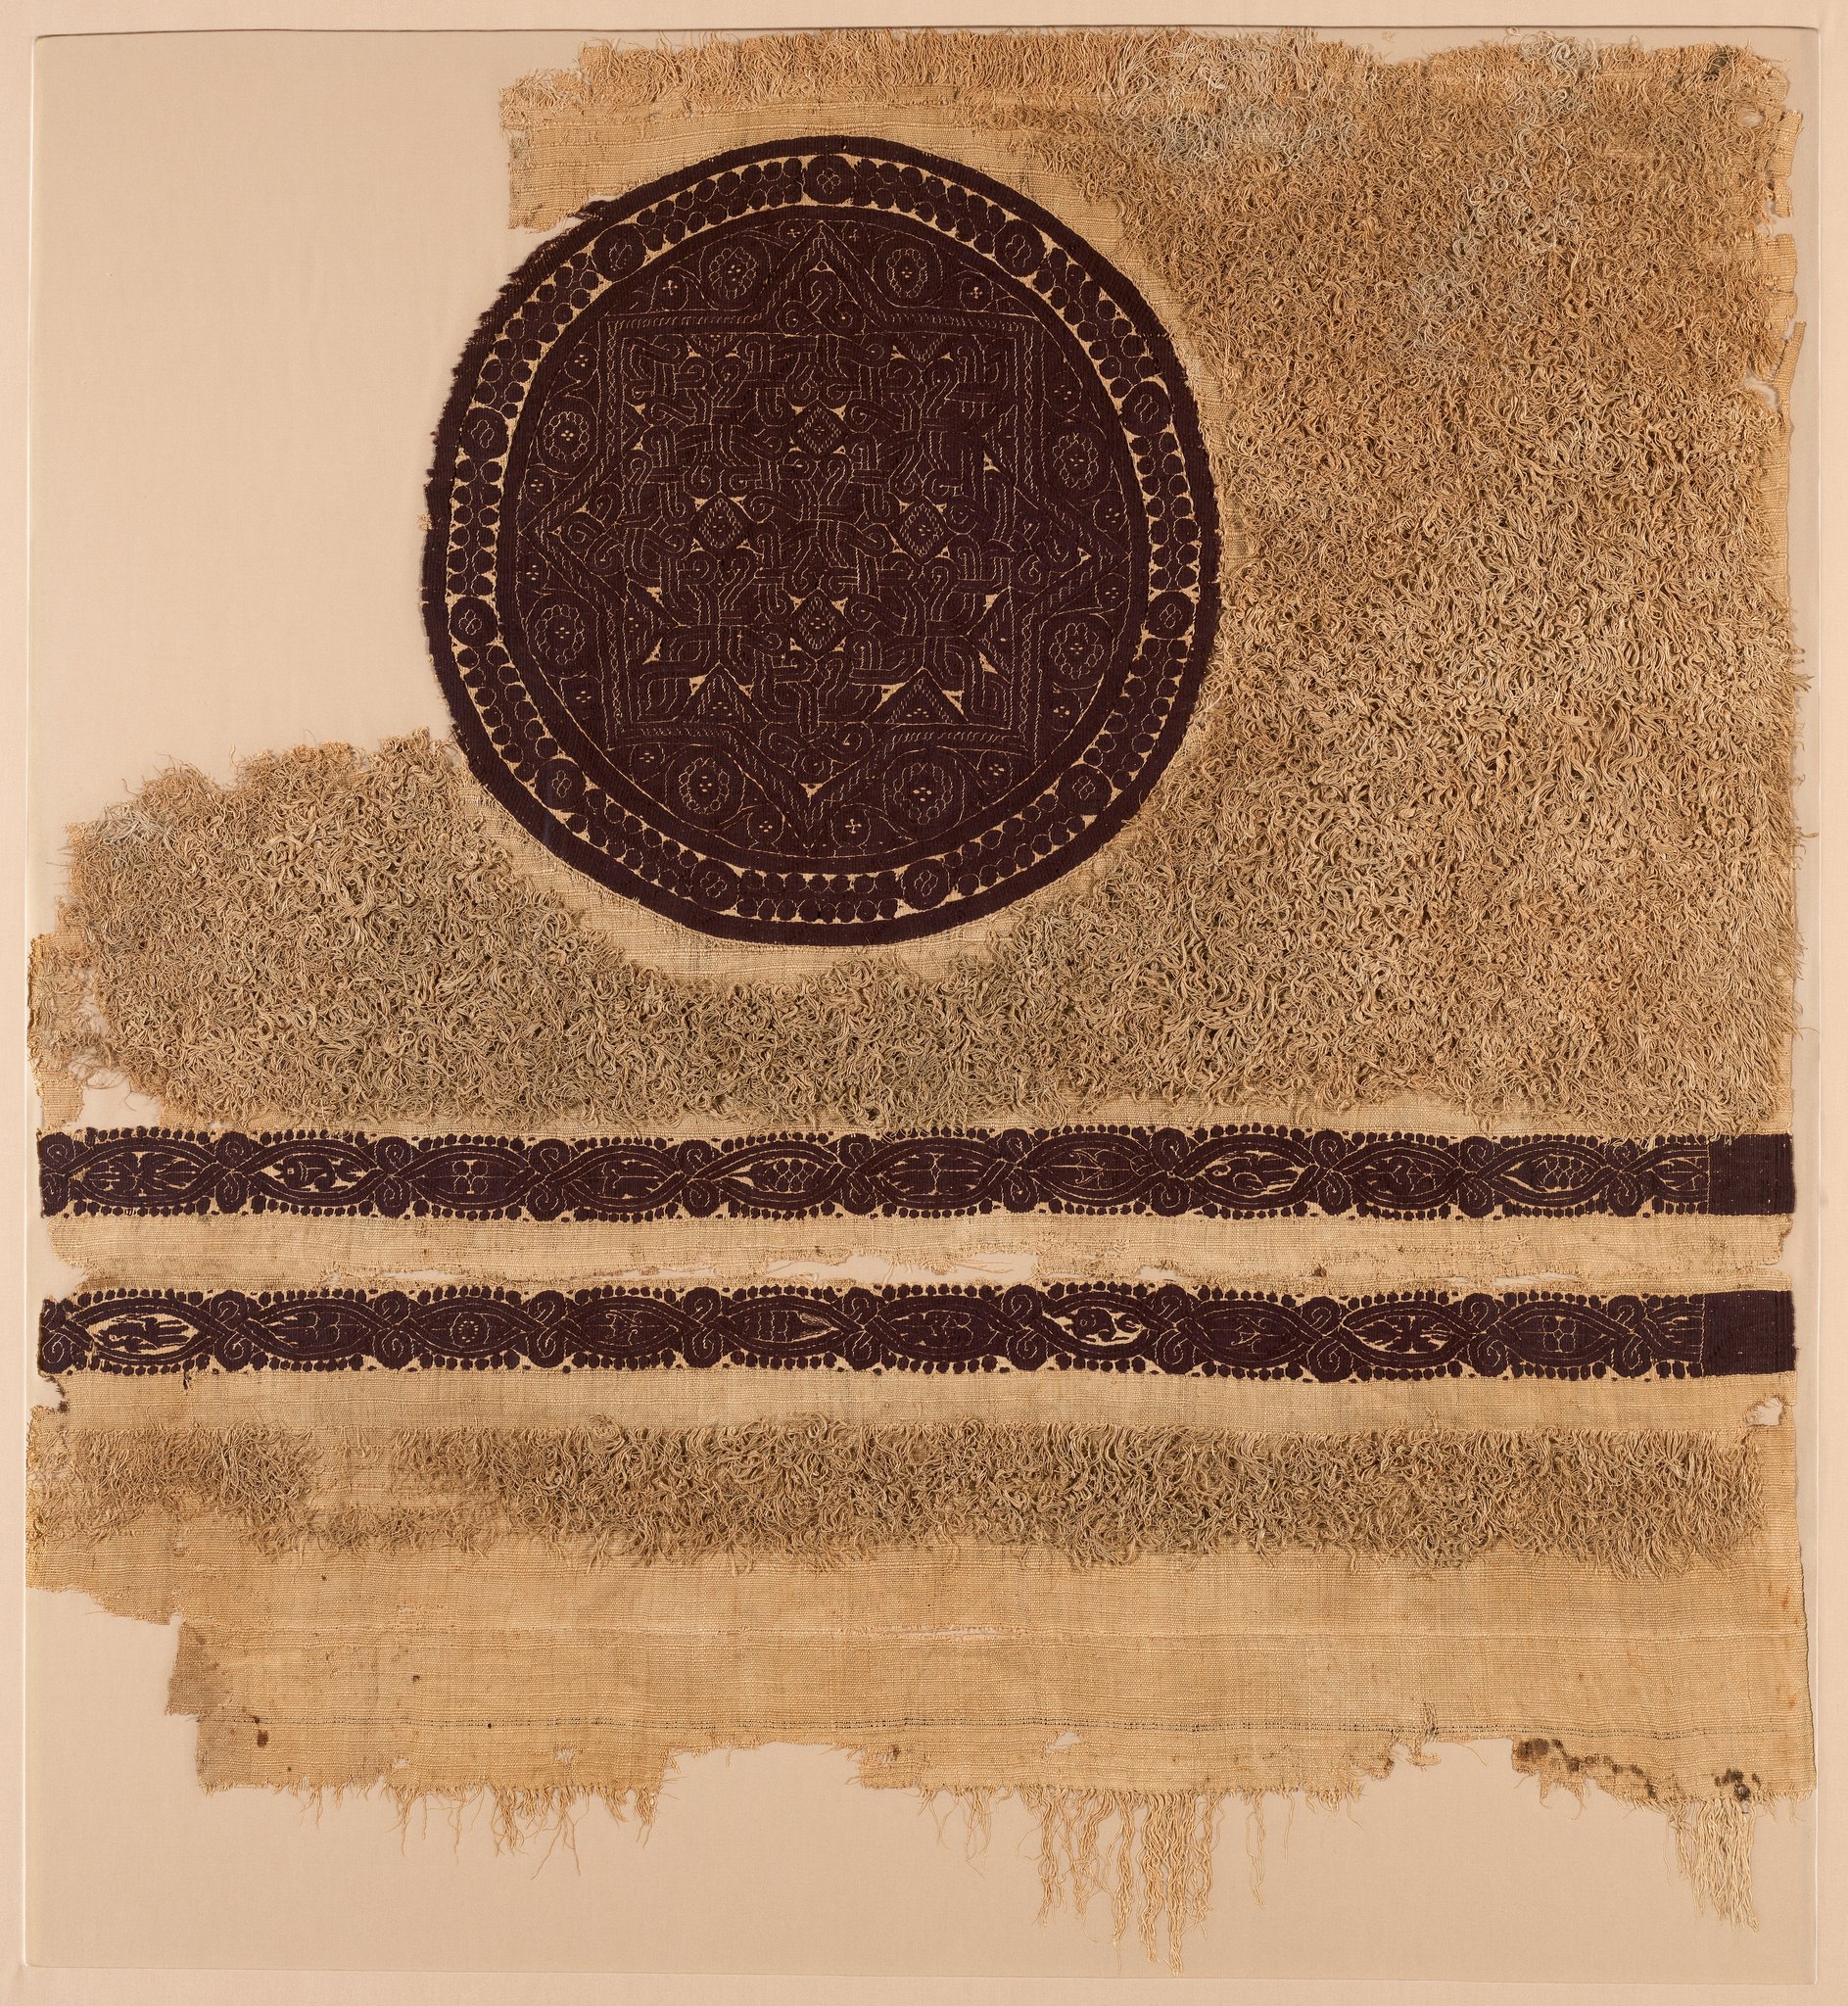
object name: textile fragment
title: Fragment of a Cover or Blanket with Interlace Roundel and Stripes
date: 201-500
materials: linen, wool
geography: egypt